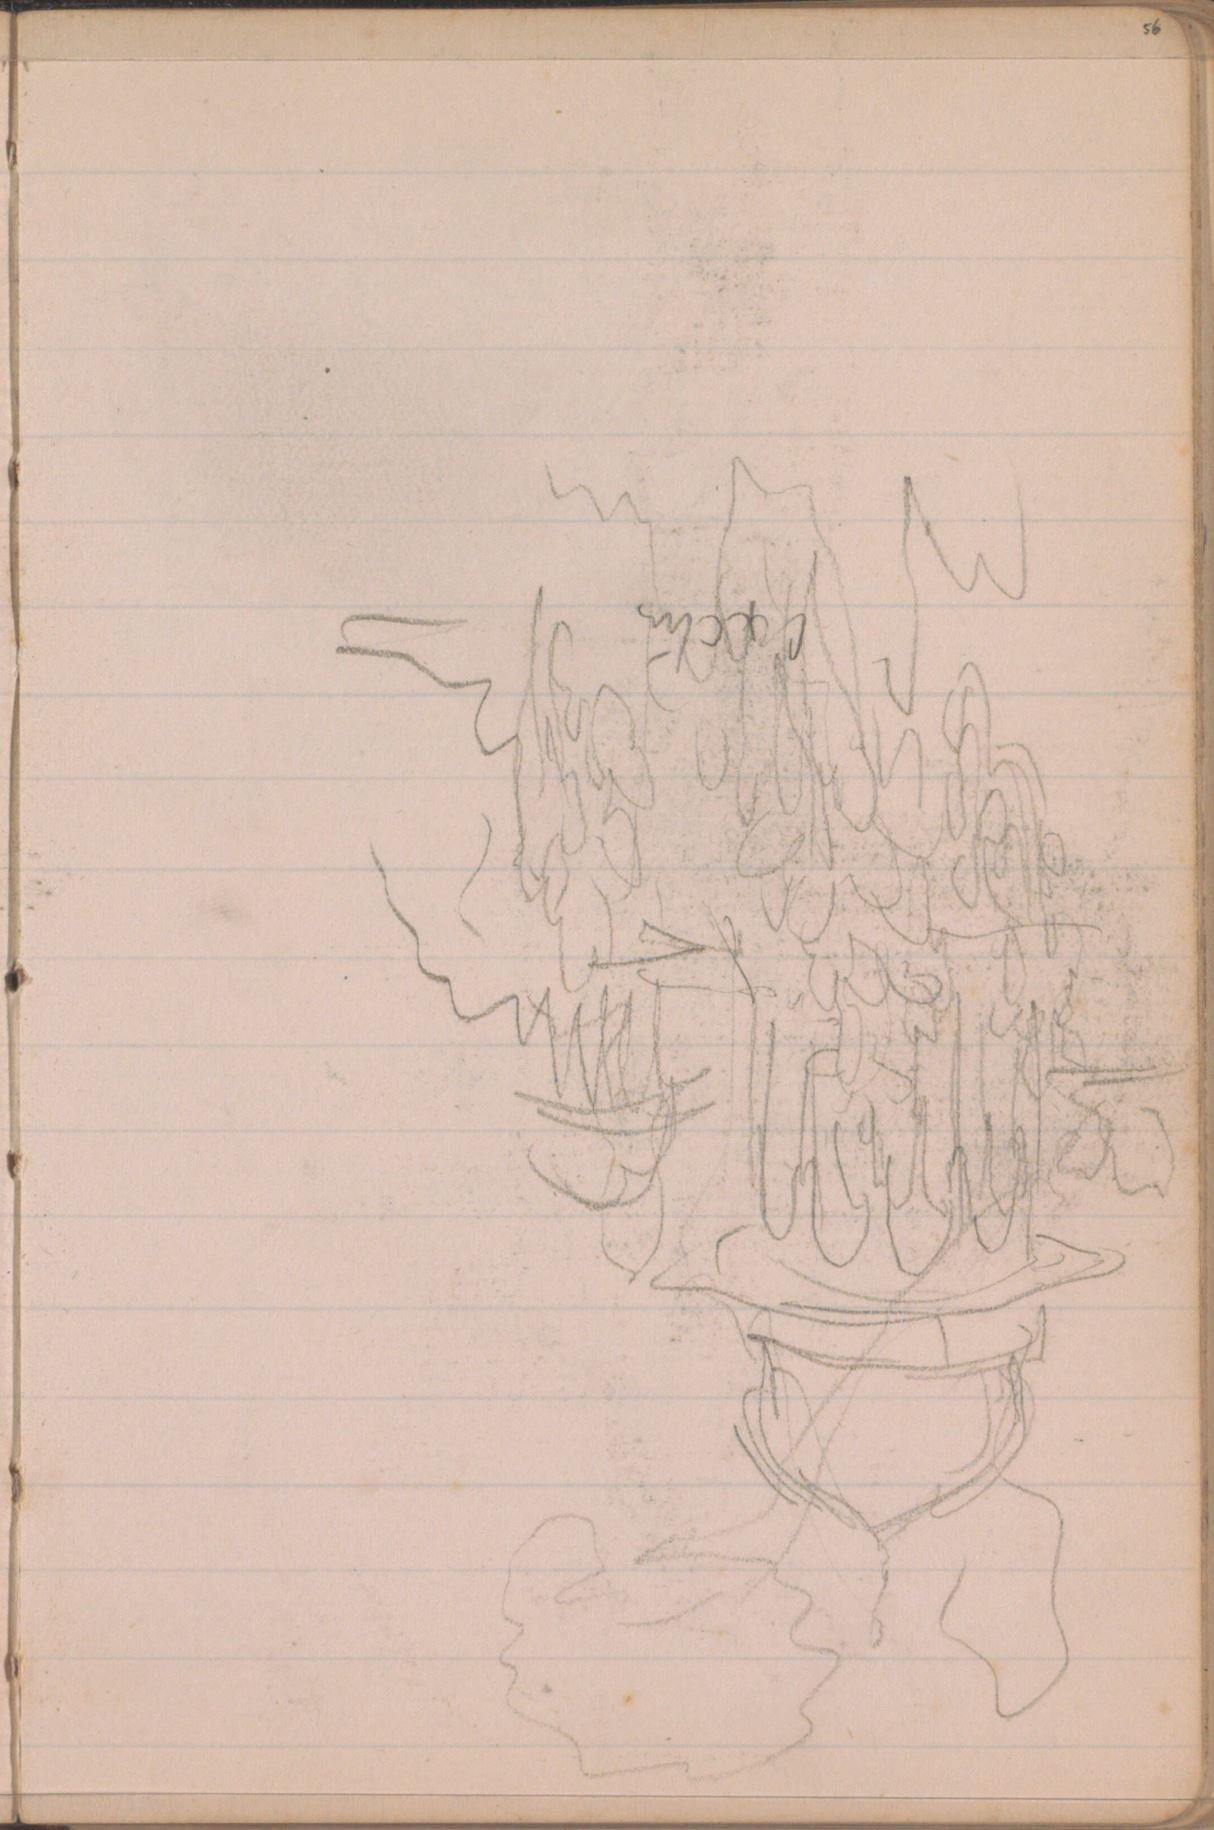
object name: sketchbook leaf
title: Tempels met koepeldaken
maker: marius bauer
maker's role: draughtsman, print maker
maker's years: 1867-1932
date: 1897-1898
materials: pencil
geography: india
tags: temple, shrine ~ hinduism, buddhism, jainism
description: Pagina 56 uit een schetsboek met 84 bladen.